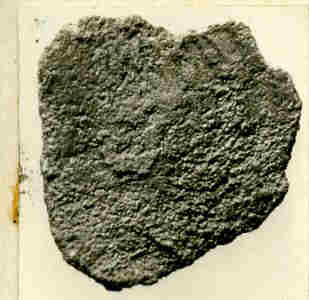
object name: coin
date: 701-900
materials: copper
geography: iran